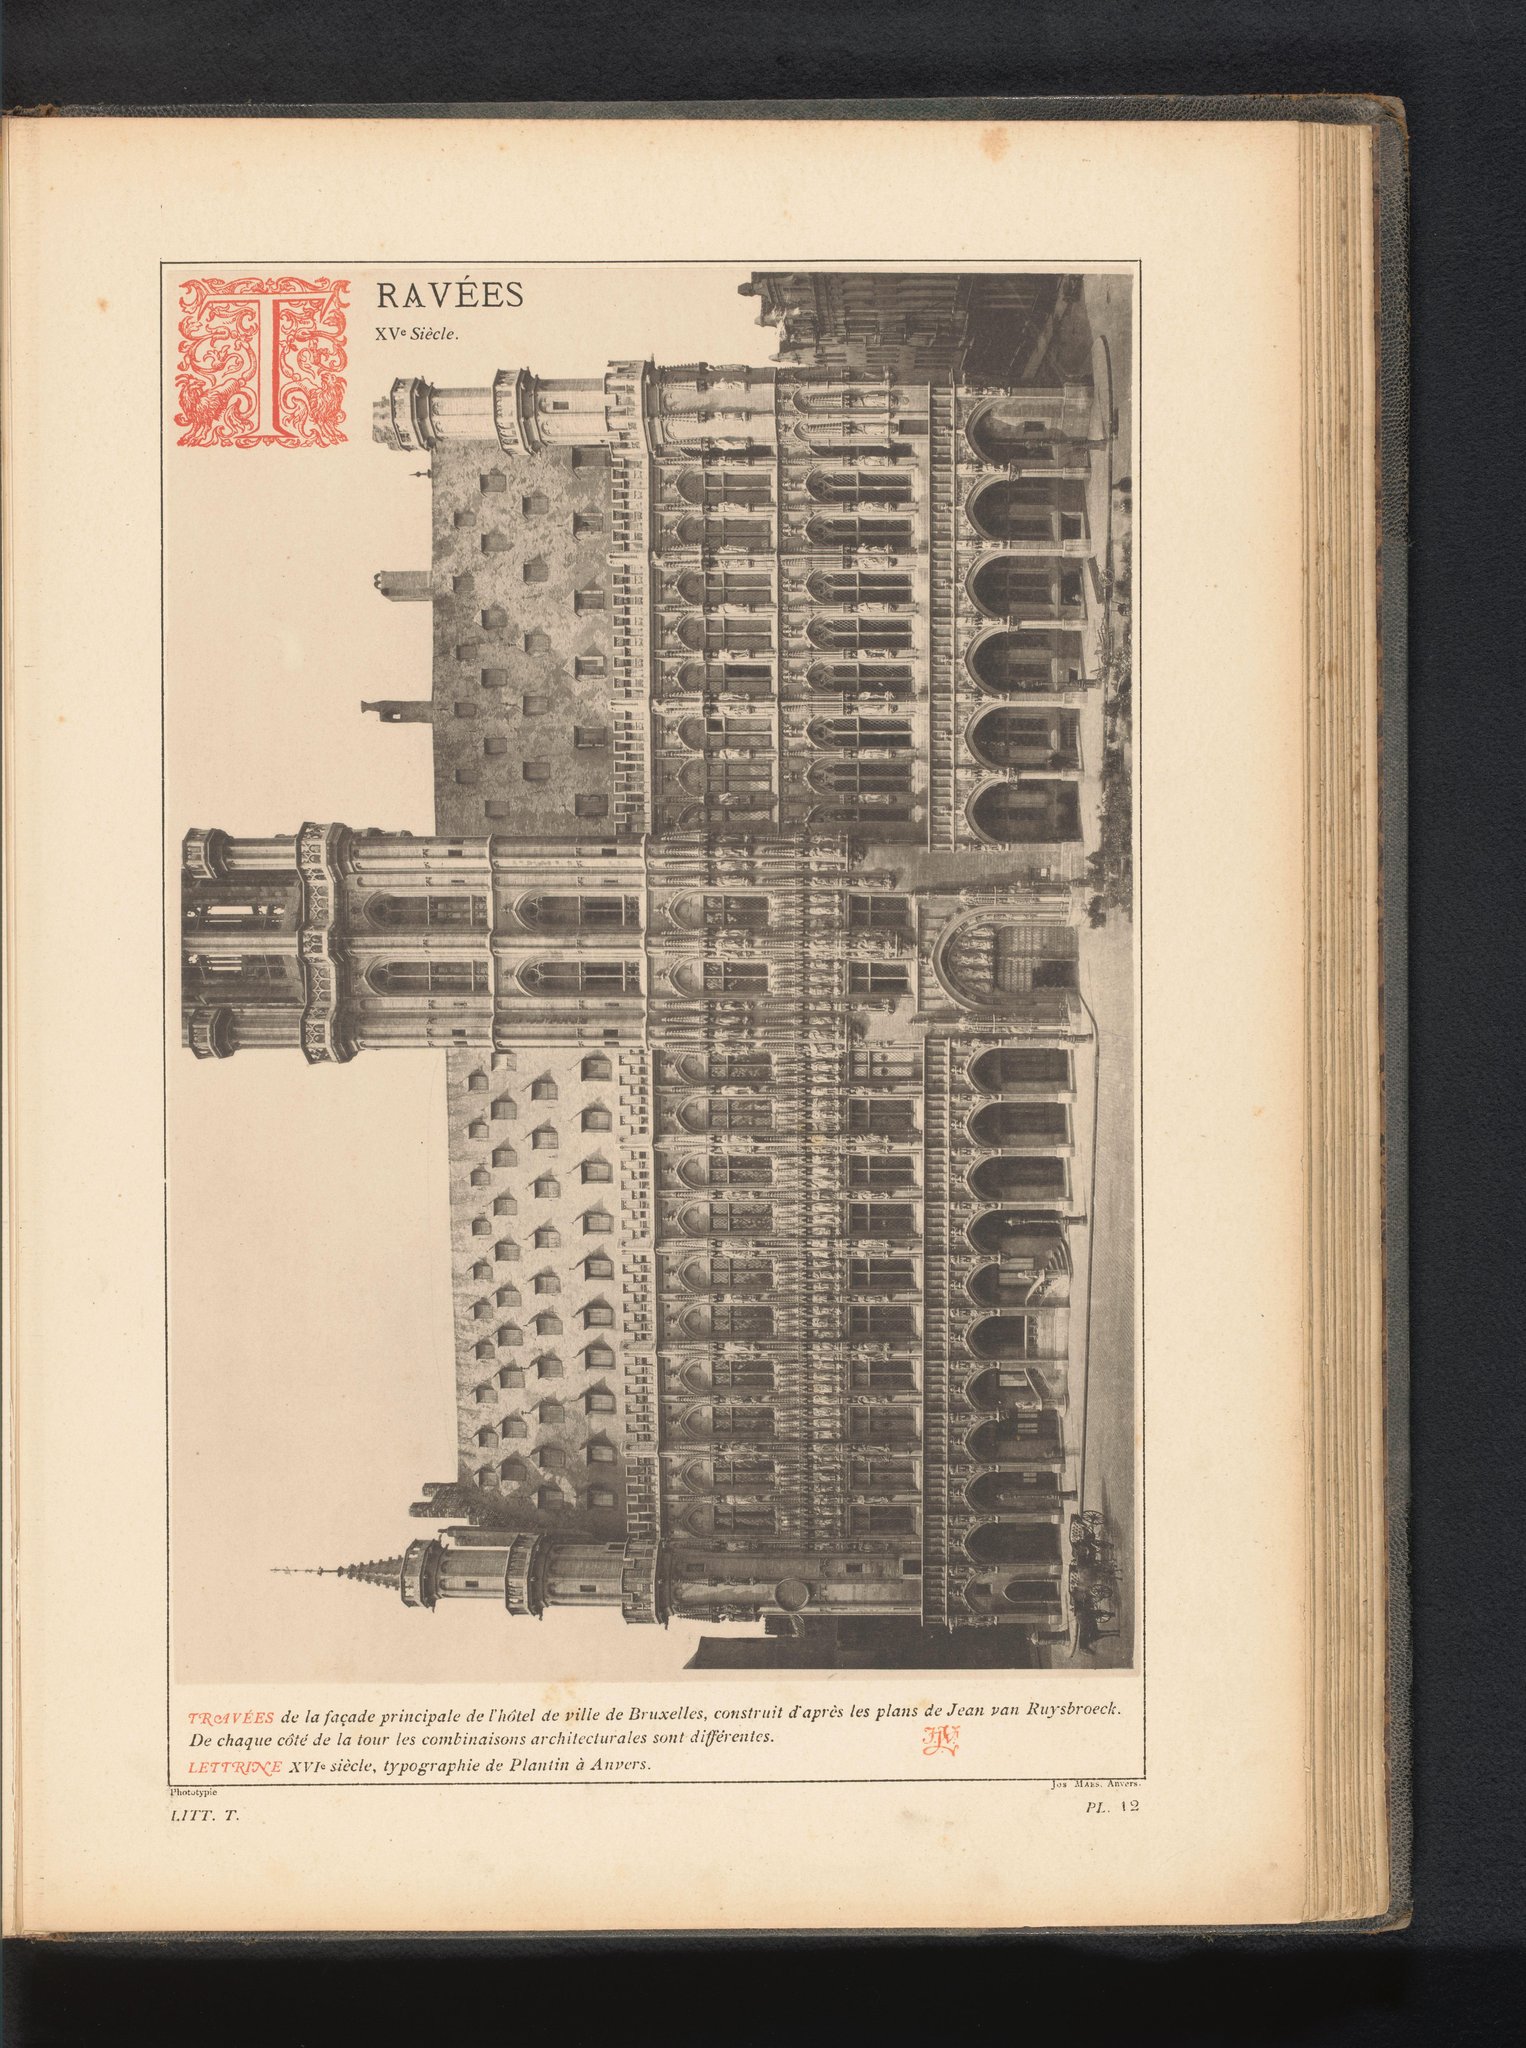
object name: photomechanical print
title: Travées, XVe Siècle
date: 1876-1881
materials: paper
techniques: photograph, photolithography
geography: antwerp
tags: townhall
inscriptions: inscription: ‘LITT. T. - PL. 12.’, monogram: ‘JJvY’, inscription: ‘TRAVÉES de la (...)’